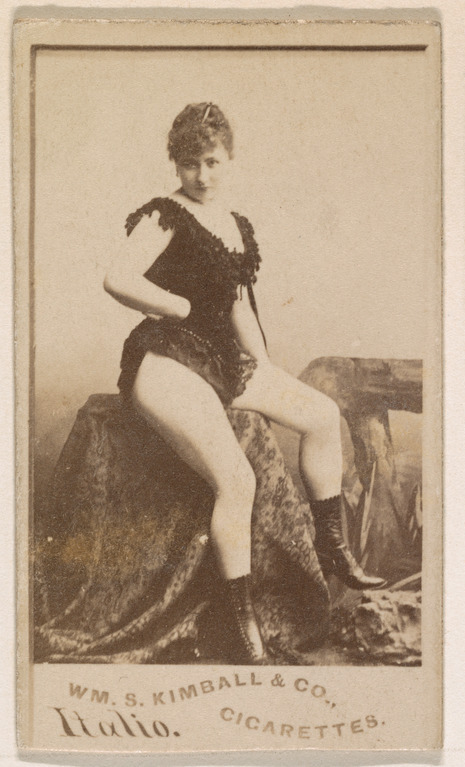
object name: photograph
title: Miss Italio, from the Actresses series (N203) issued by Wm. S. Kimball & Co.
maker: william s. kimball & company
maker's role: publisher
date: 1889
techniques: color lithograph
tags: portraits,women,actresses